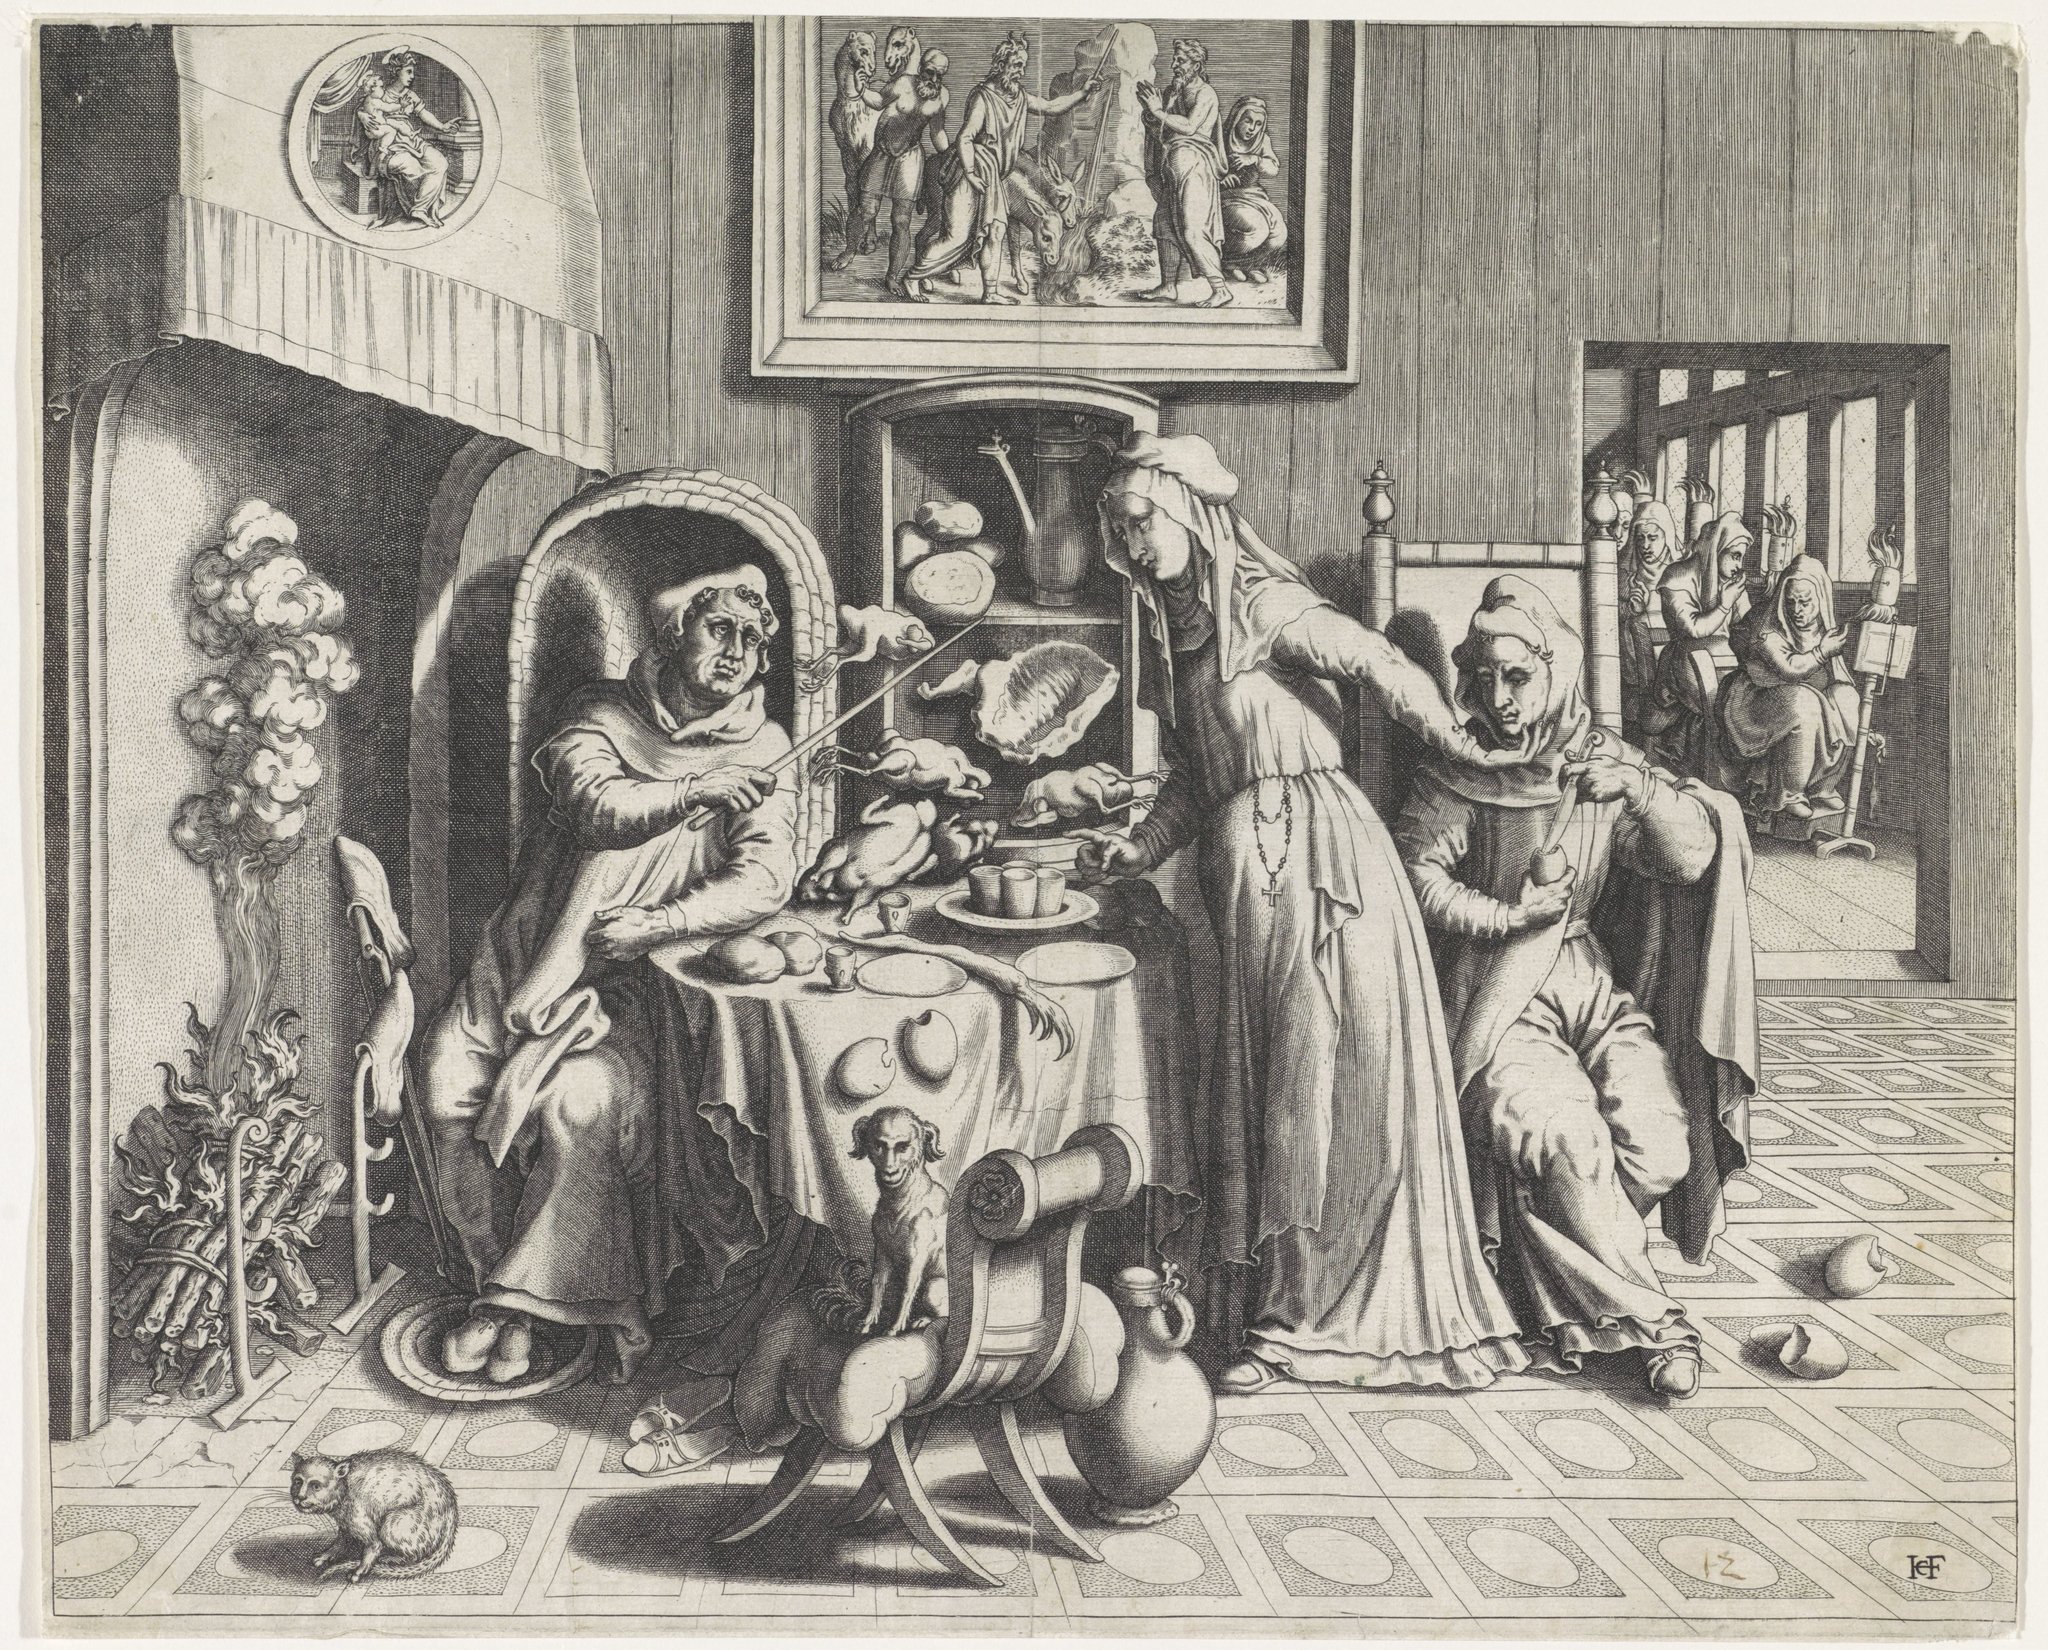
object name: print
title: Non tussen een prior en een jonge monnik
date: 1550-1600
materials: paper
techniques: engraving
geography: amsterdam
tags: monks and nuns, spinning (manufacture of yarn), laid table: table-ware, table-decoration, etc., moses striking water from the rock (exodus 17:1-7; numbers 20:2-13), hidden love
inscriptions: collector's mark: Lugt 2228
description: Een prior en een jonge monnik zitten aan een gedekte tafel voor een haardvuur. Voor de prior staat een jonge non, die door hem terechtgewezen wordt. Achter haar rug streelt de non het gezicht van de jonge monnik. De haard is versierd met een medaillon waarop Maria met het Christuskind. Achter het gezelschap hangt een voorstelling van Mozes die water uit de rots slaat voor de Israëlieten. Rechtsachter zitten nonnen te spinnen.